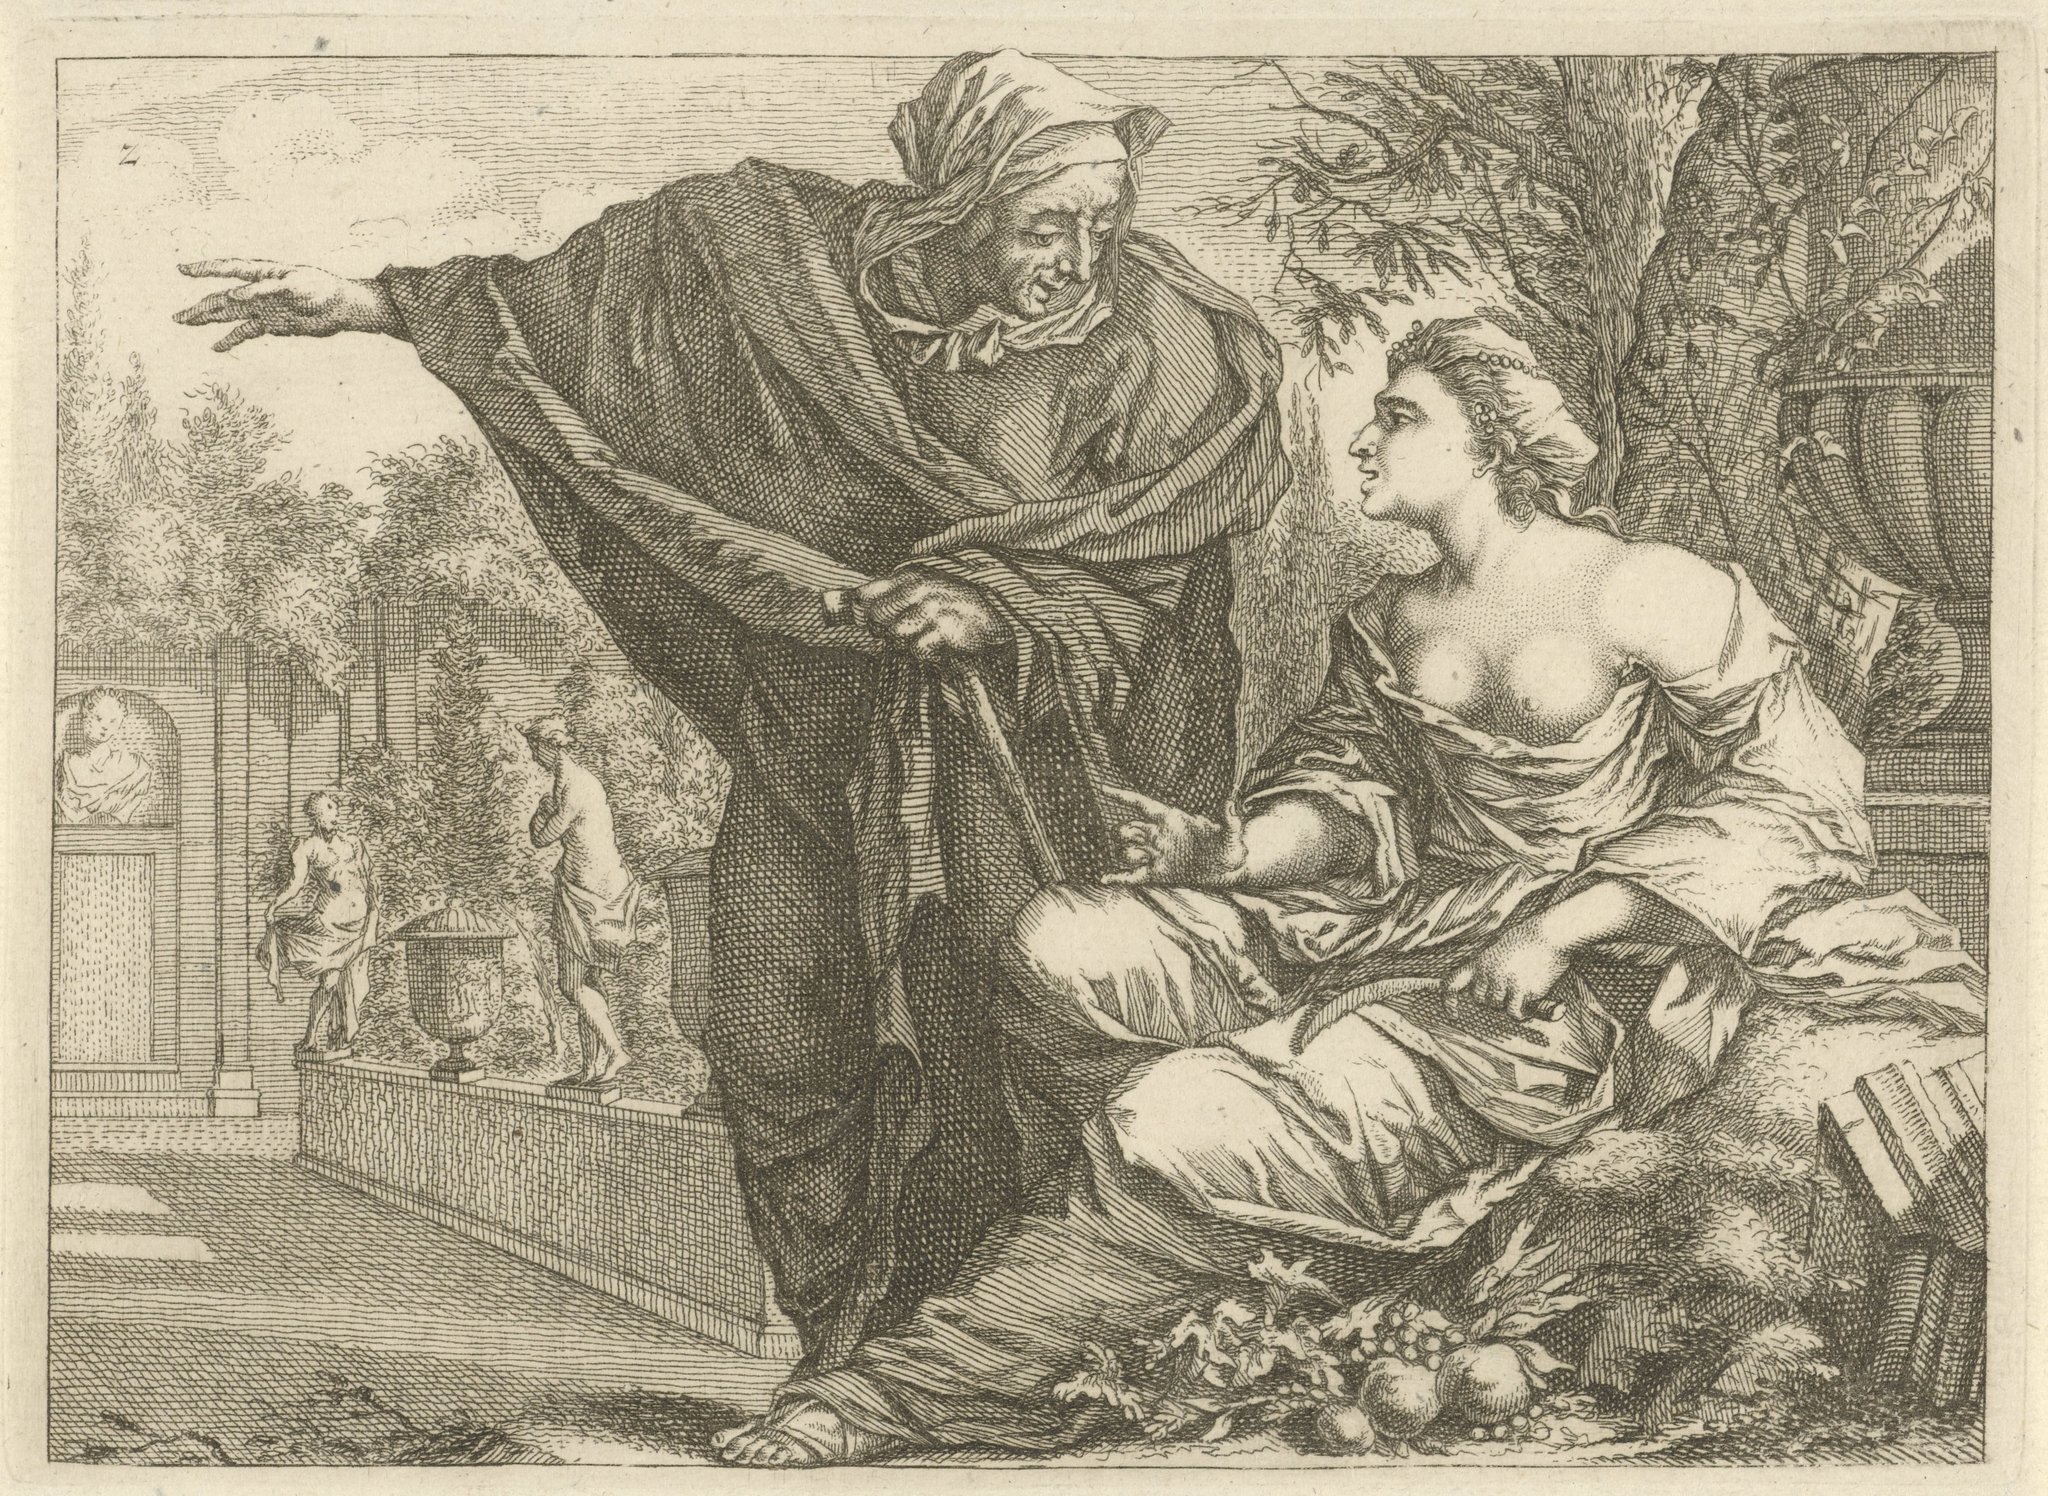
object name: print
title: Vertumnus en Pomona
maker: Anonymous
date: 1700-1750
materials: paper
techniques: engraving, etching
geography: northern netherlands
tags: vertumnus and pomona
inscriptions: collector's mark: Lugt 2228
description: Vertumnus, vermomd als oude vrouw, in gesprek met Pomona, zittend in een klassieke tuin. Kopie naar de prent van Houbraken uit deel 2 van een serie prenten met zinnebeelden.